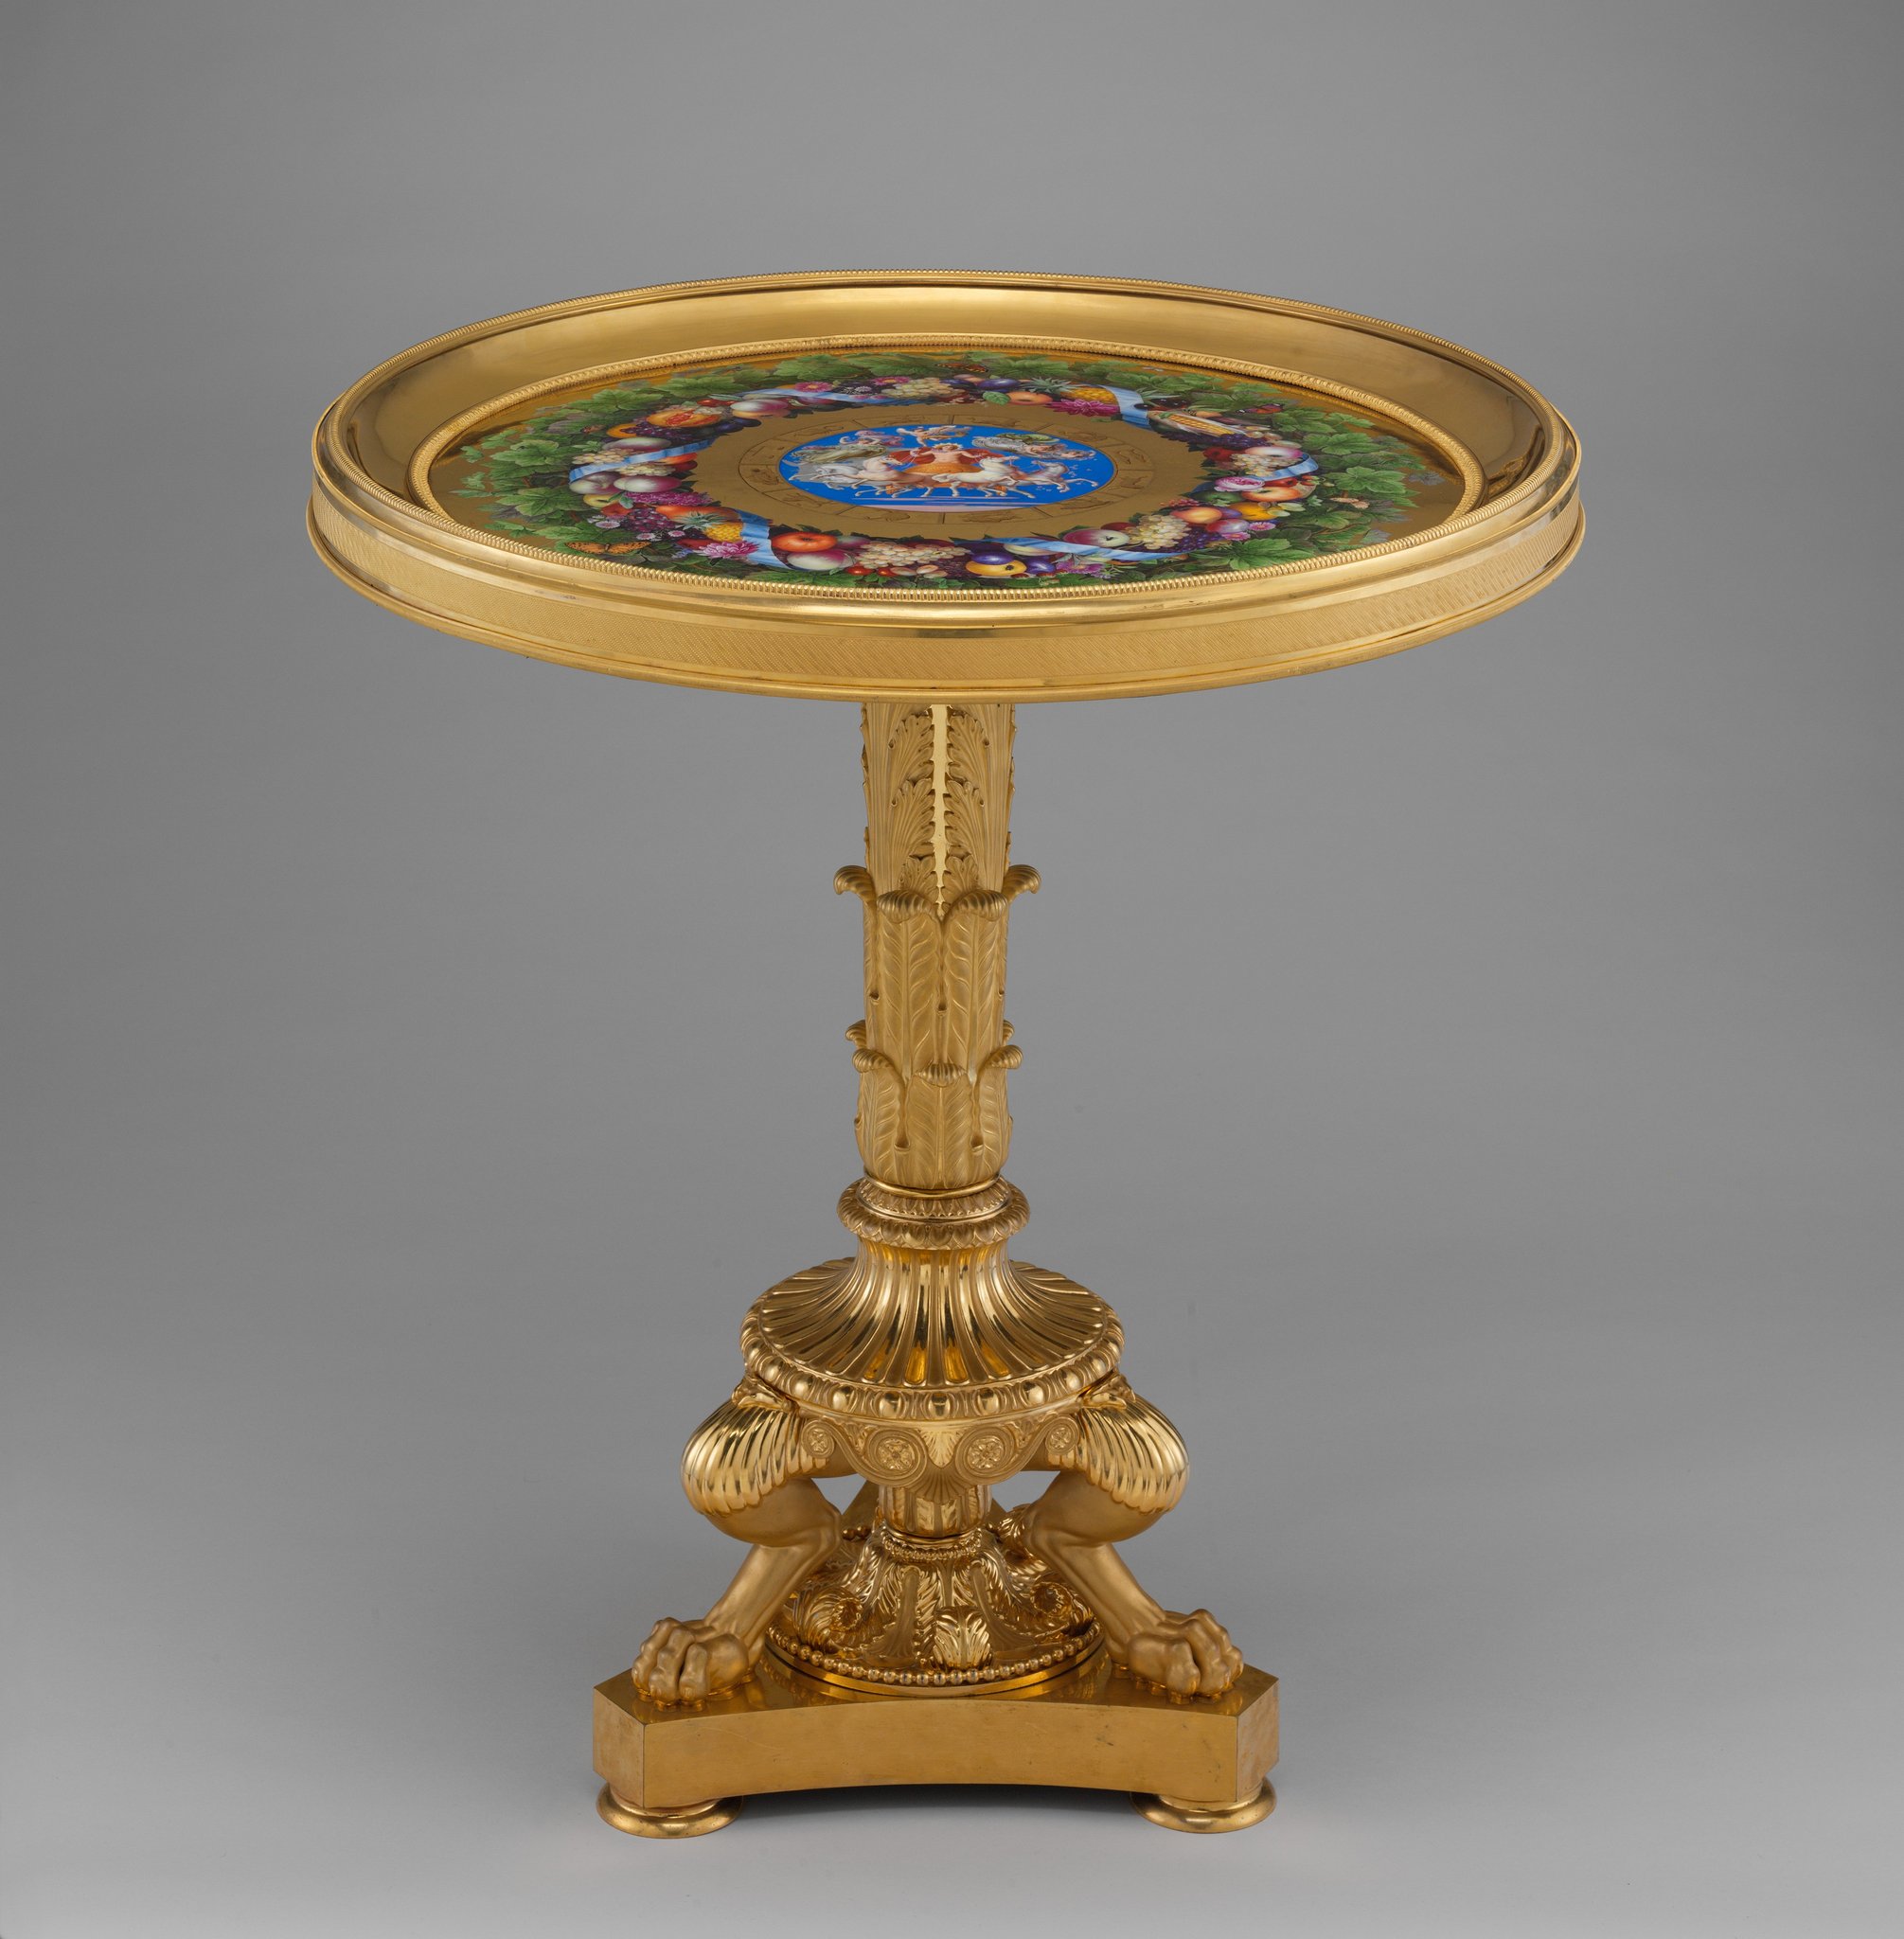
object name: table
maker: royal porcelain manufactory, berlin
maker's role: manufactory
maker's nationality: german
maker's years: 1763-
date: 1833-1834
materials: bronze, hard paste porcelain, iron, metal, wood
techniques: gilding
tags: fruit,men,horses,leaves